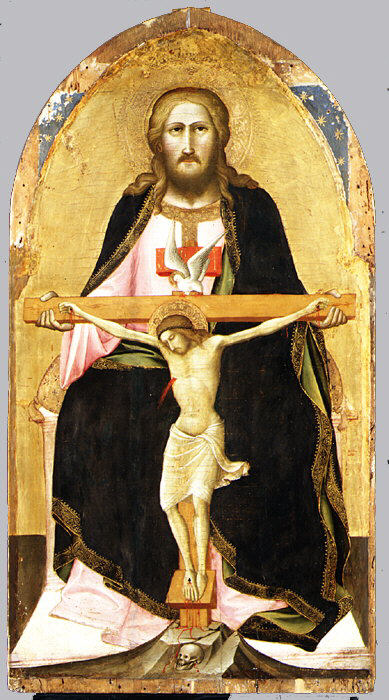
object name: painting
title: The Trinity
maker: agnolo gaddi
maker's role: artist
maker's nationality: italian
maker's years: 1369-1396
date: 1390-1396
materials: gold leaf, paint, wood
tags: doves,christ,gods,crucifixion